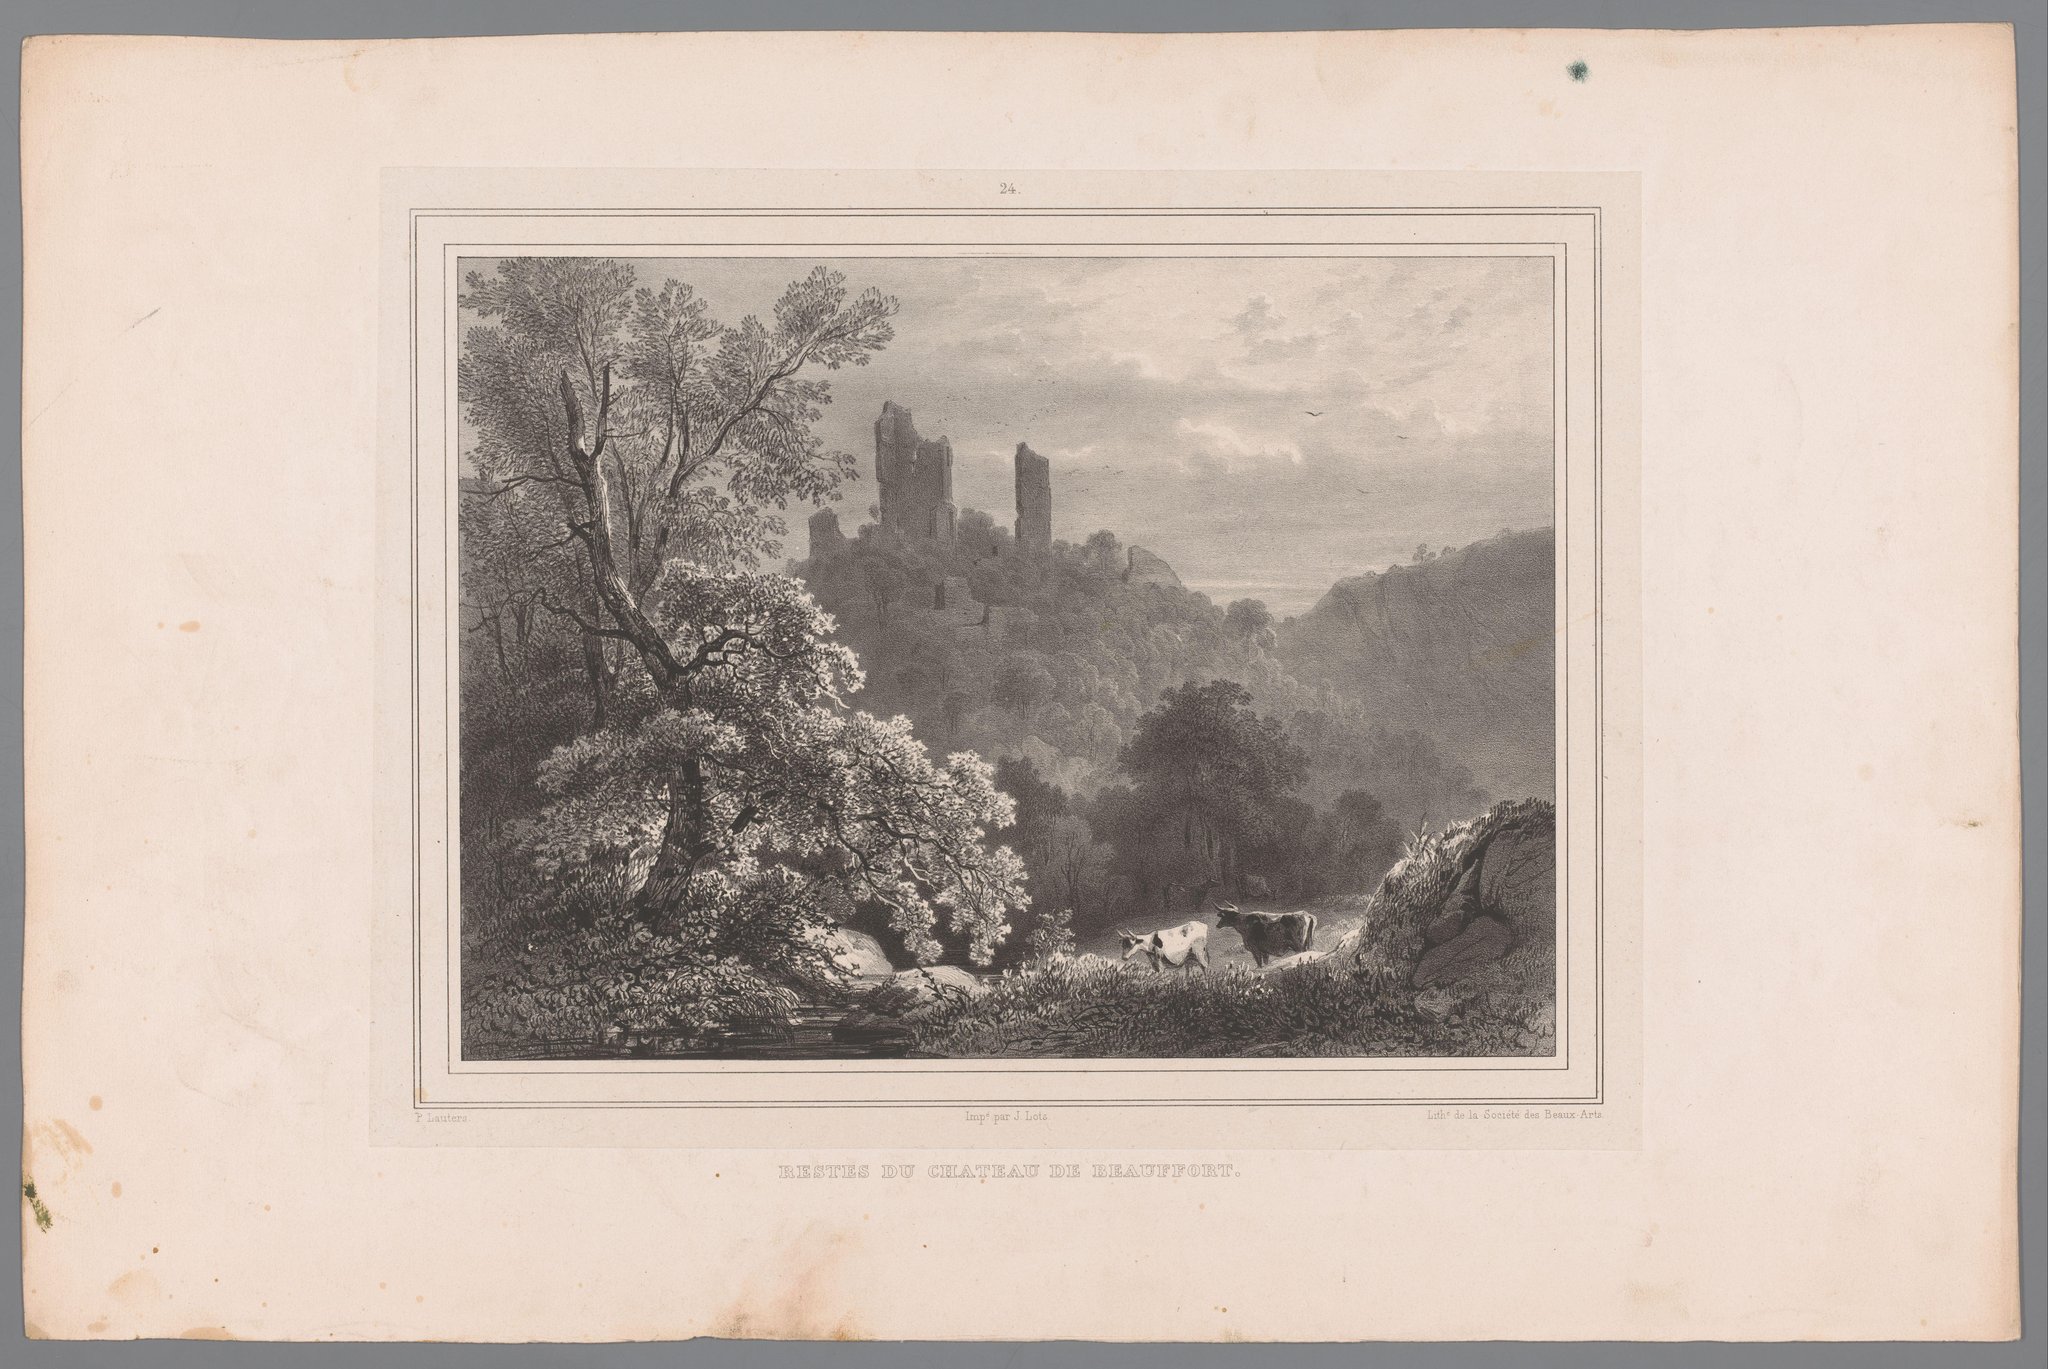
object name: print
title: Landschap met de ruïne van Beauffort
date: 1839-1841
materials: paper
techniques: lithograph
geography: brussels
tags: landscape with ruins, namur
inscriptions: collector's mark: Lugt 2228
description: Prent verschenen in: Van Hasselt, André. Voyage aux bords de la Meuse. Brussel: Société des Beaux-Arts, 1839-1841. Deze publicatie bevat 36 litho's.